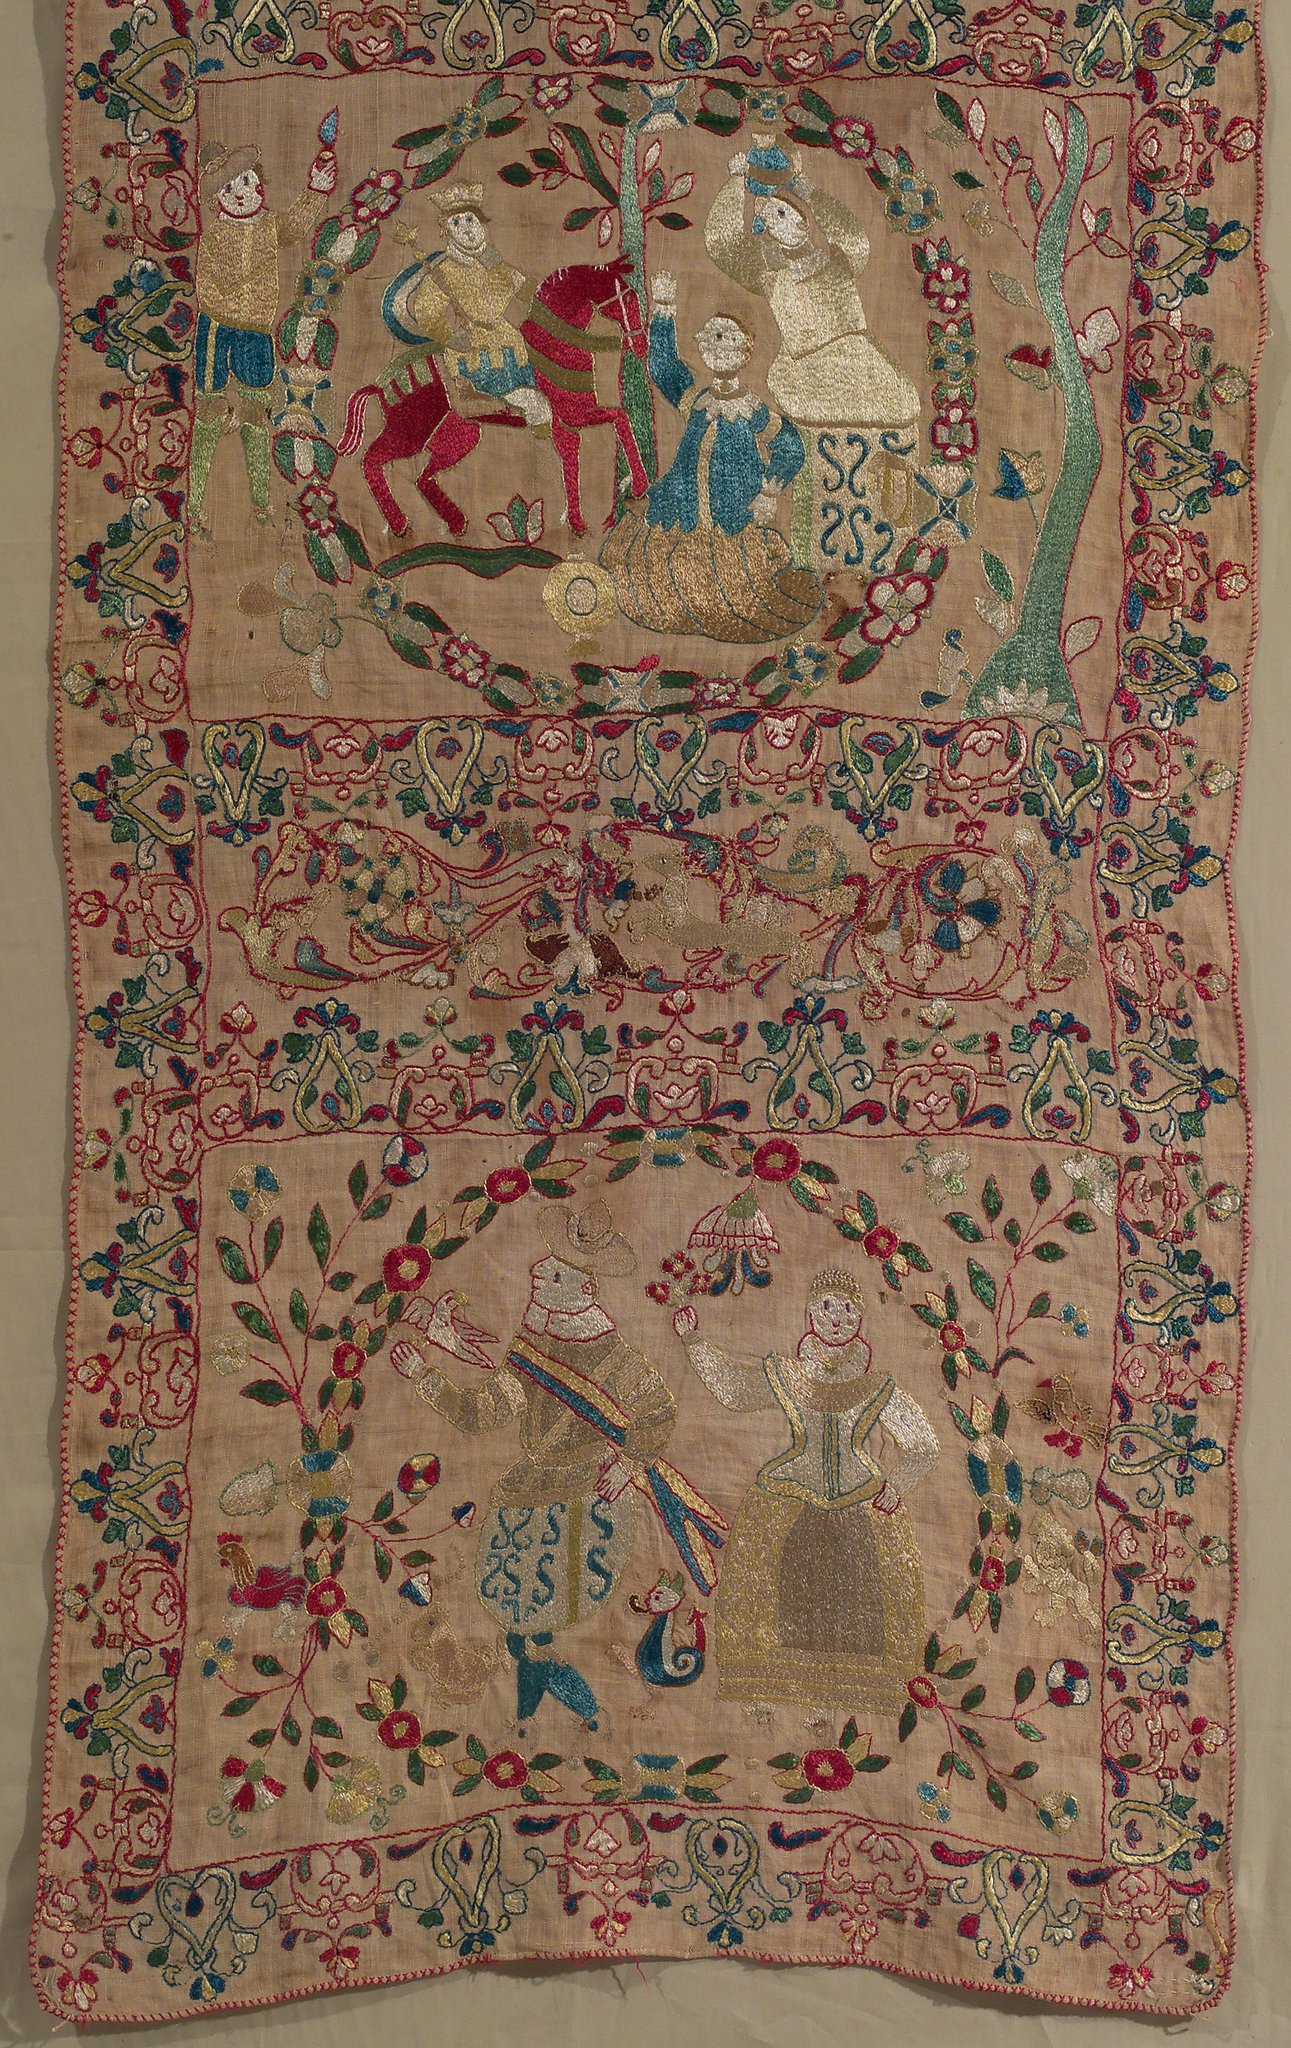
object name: panel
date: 1648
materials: linen, metal thread, silk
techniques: embroidery, weave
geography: india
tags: birds,men,women,horses